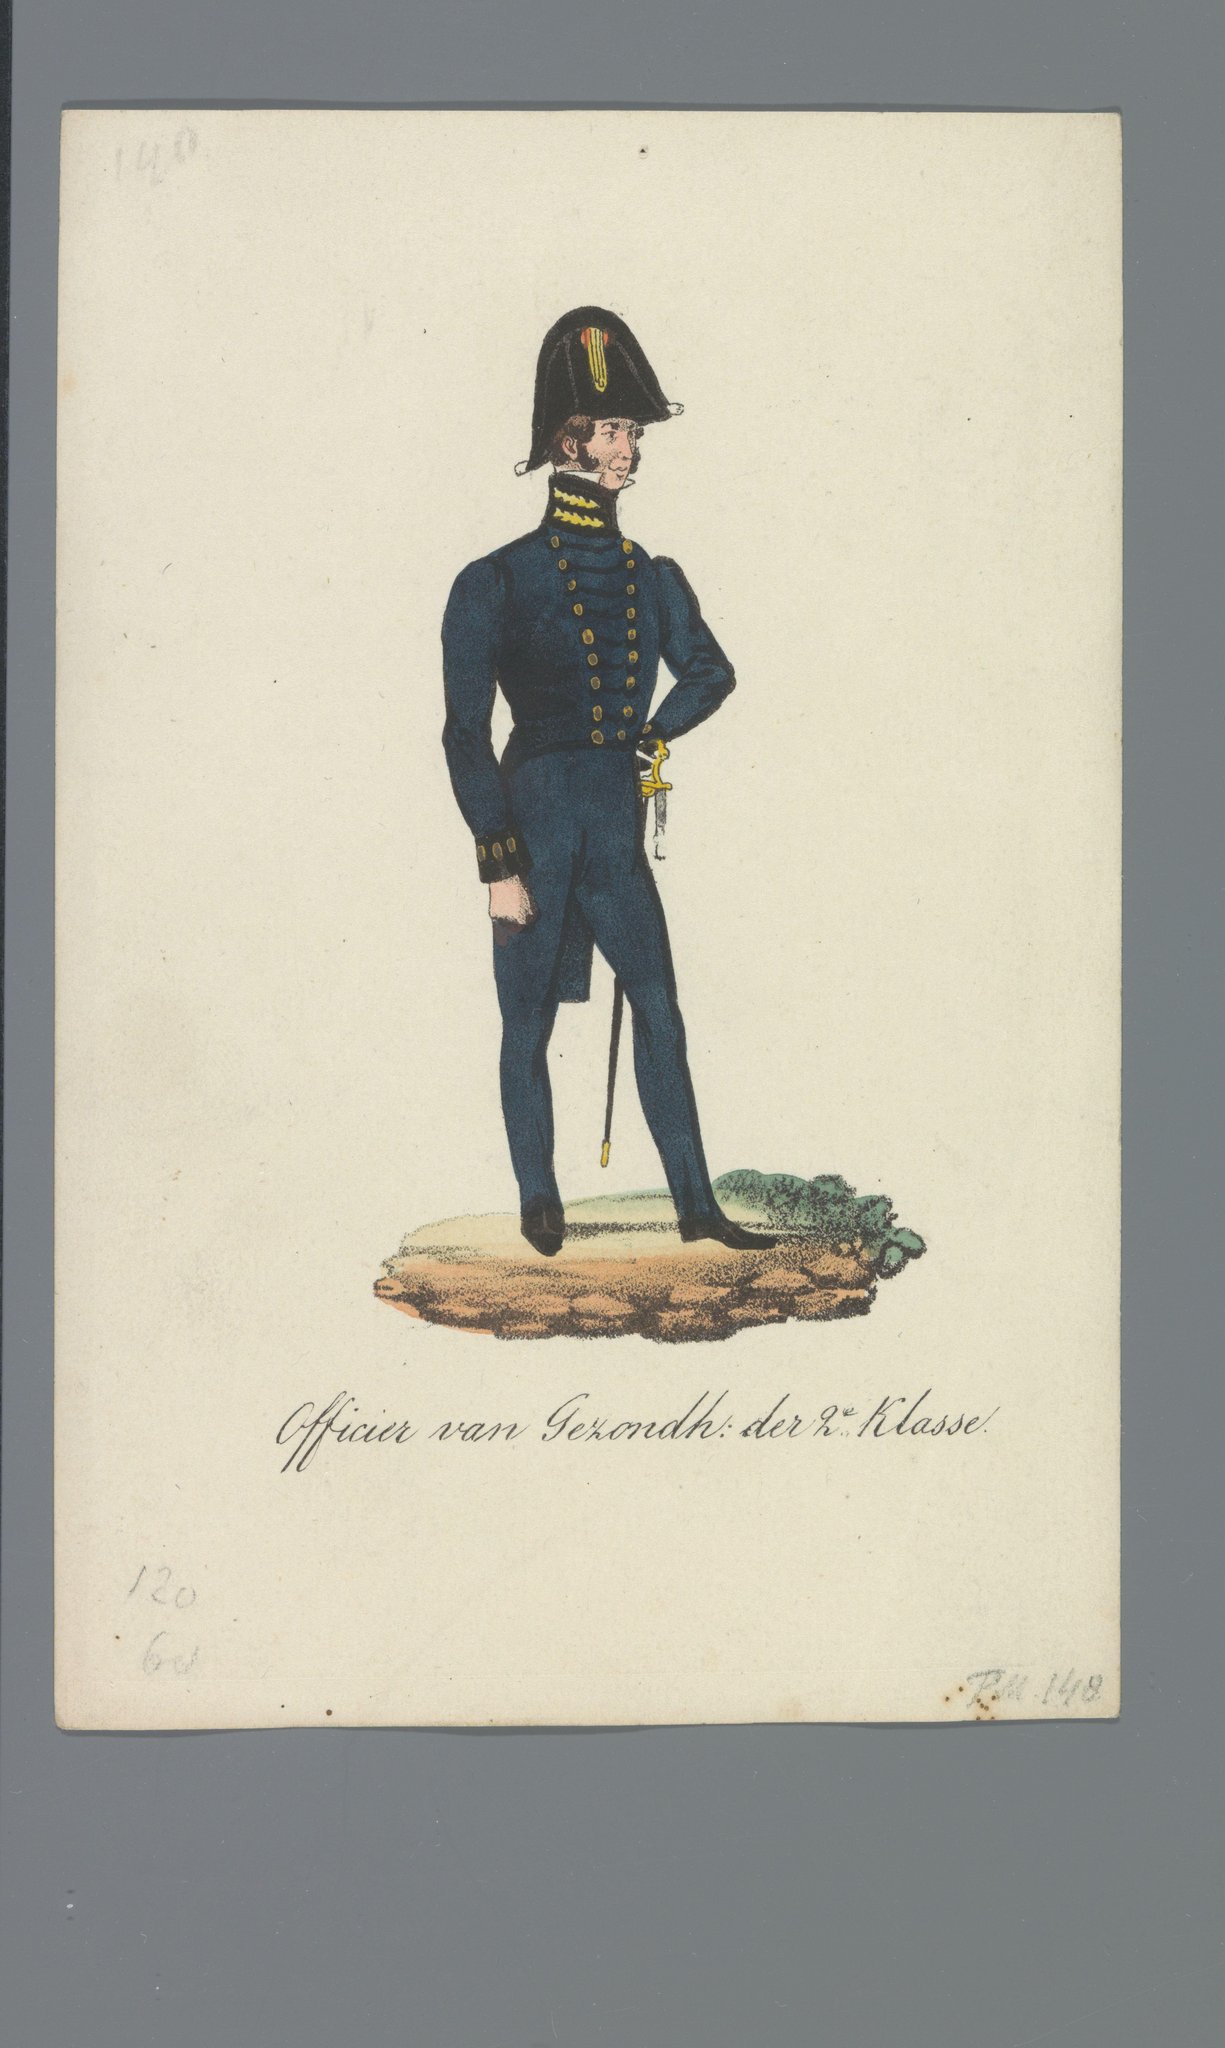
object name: print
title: Officier van Gezondh: der 2e Klasse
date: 1835-1850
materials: paper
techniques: hand coloring, lithograph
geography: utrecht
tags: clothes, costume (+ men's clothes), (military) uniforms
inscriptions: collector's mark: Lugt 2228, collector's mark: Lugt 2227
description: Een officier van gezondheid tweede klasse van de Marine, te voet. Onderdeel van een serie van 156 losse bladen met Nederlandse militaire uniformen in de jaren 1830-1832.